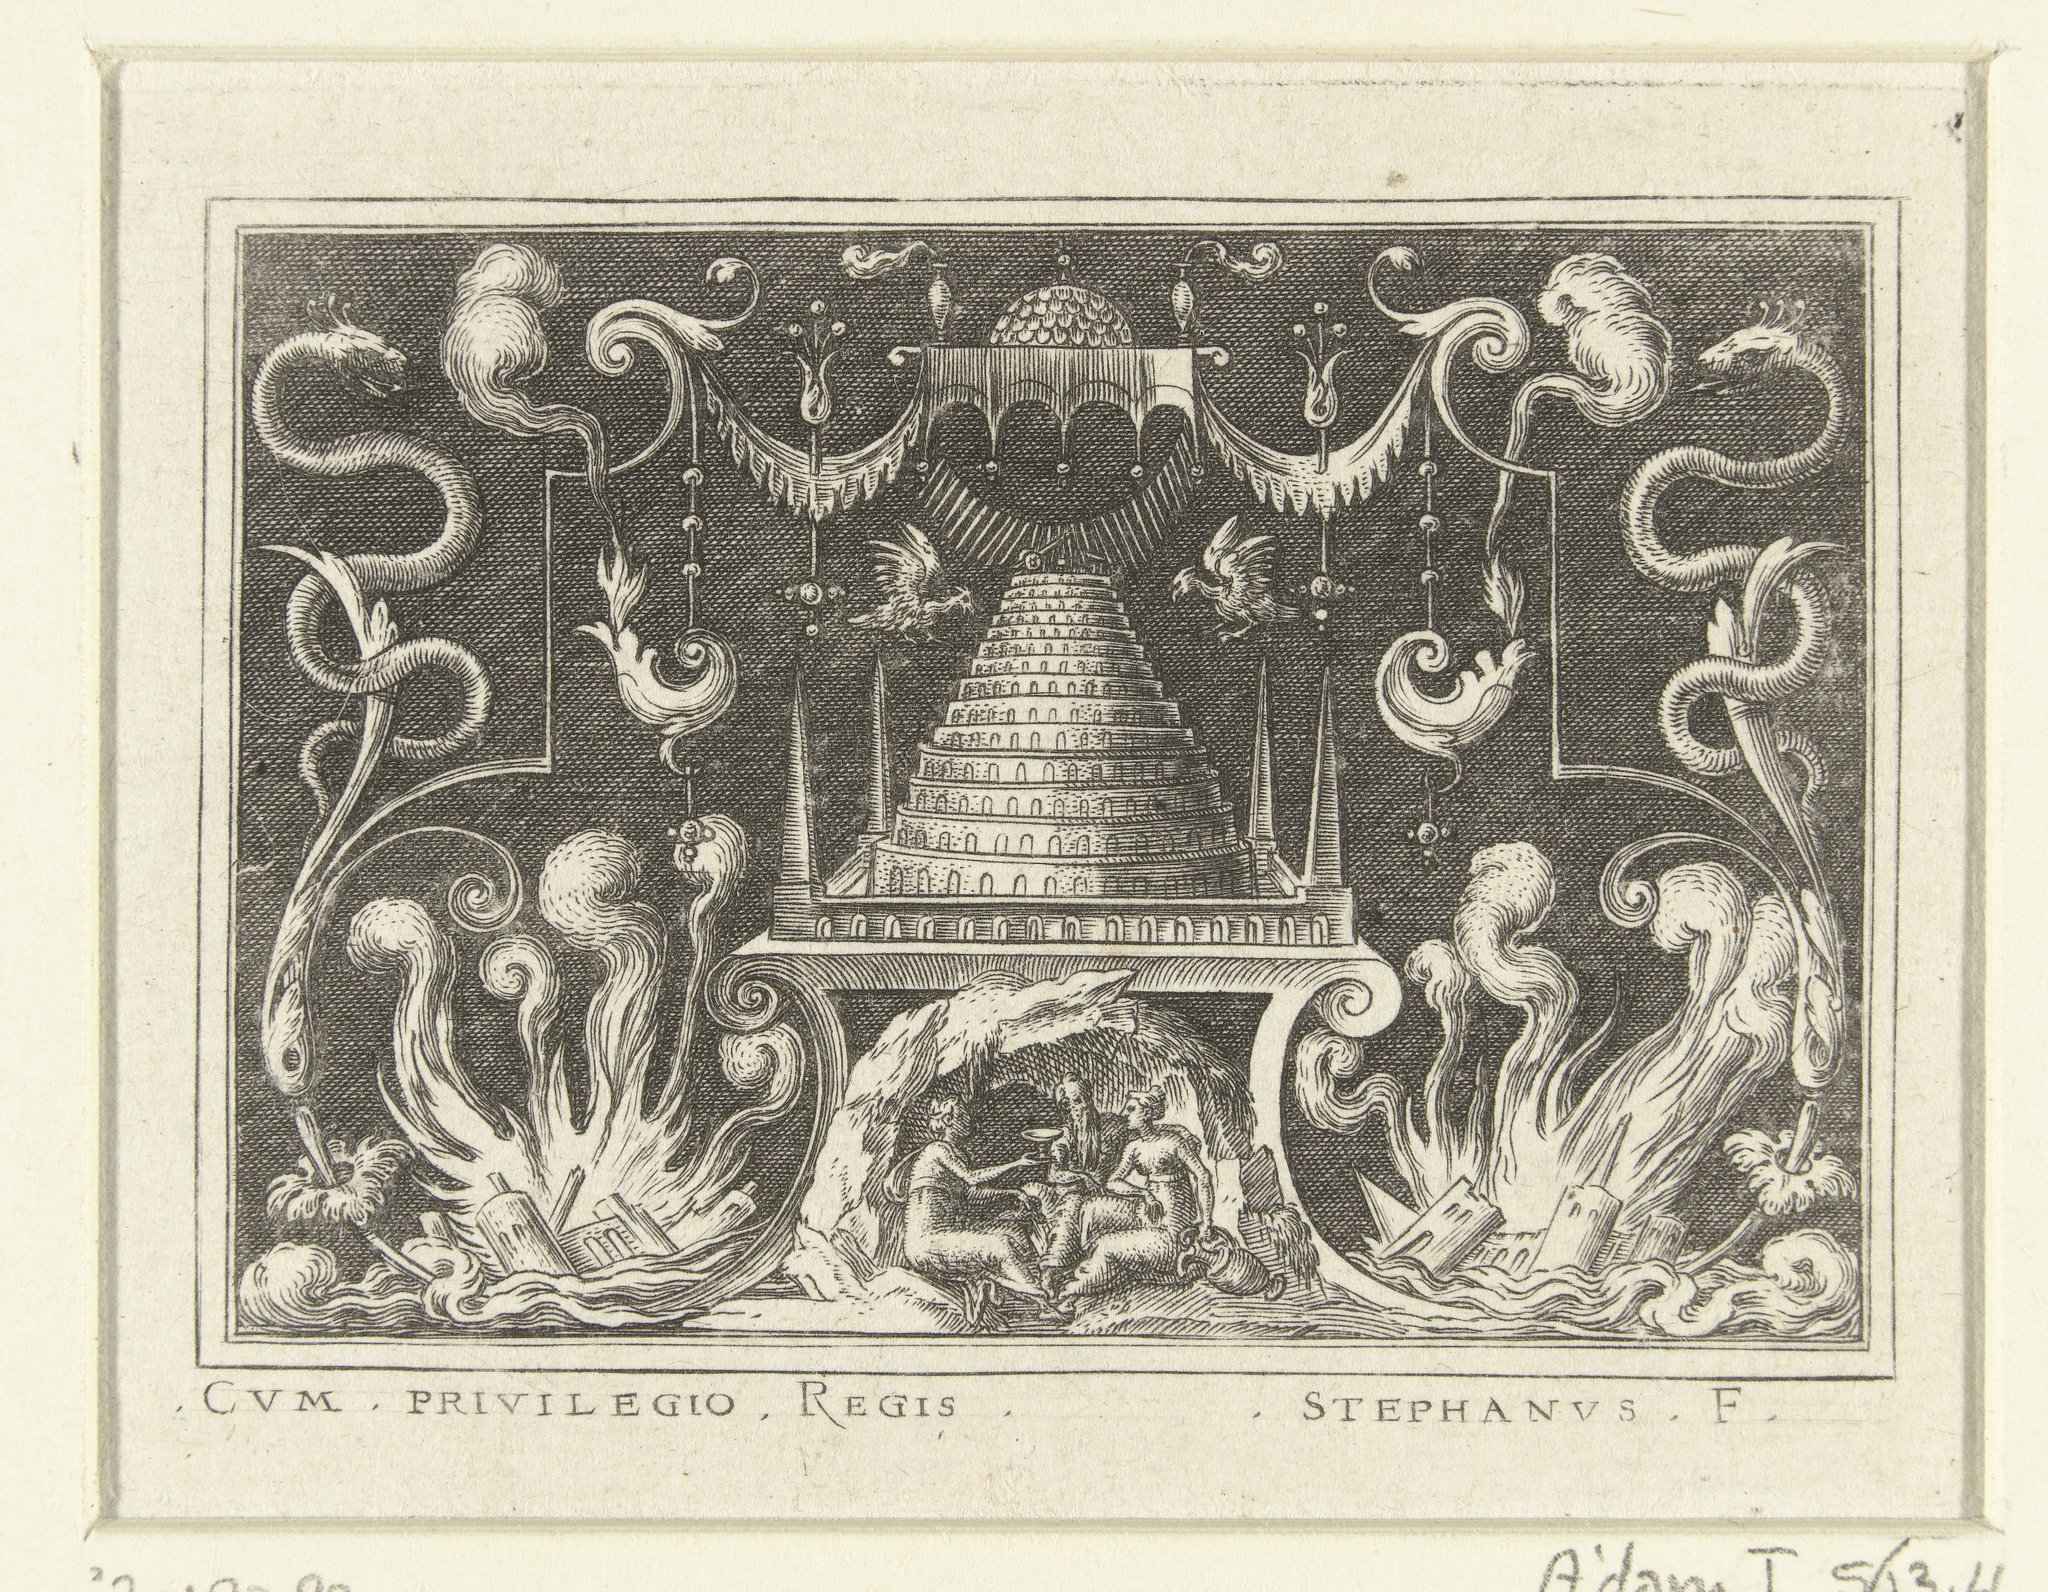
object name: print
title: Ornamentbladen. R.D. 428-433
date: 1528-1583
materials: paper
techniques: engraving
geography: france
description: Onder de toren zitten Loth en zijn dochters in een grot. Uit serie van 6 bladen.